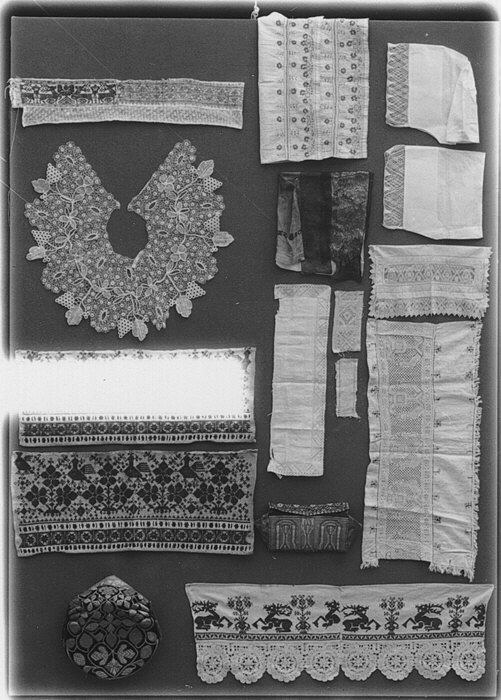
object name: border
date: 1767-1833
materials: linen